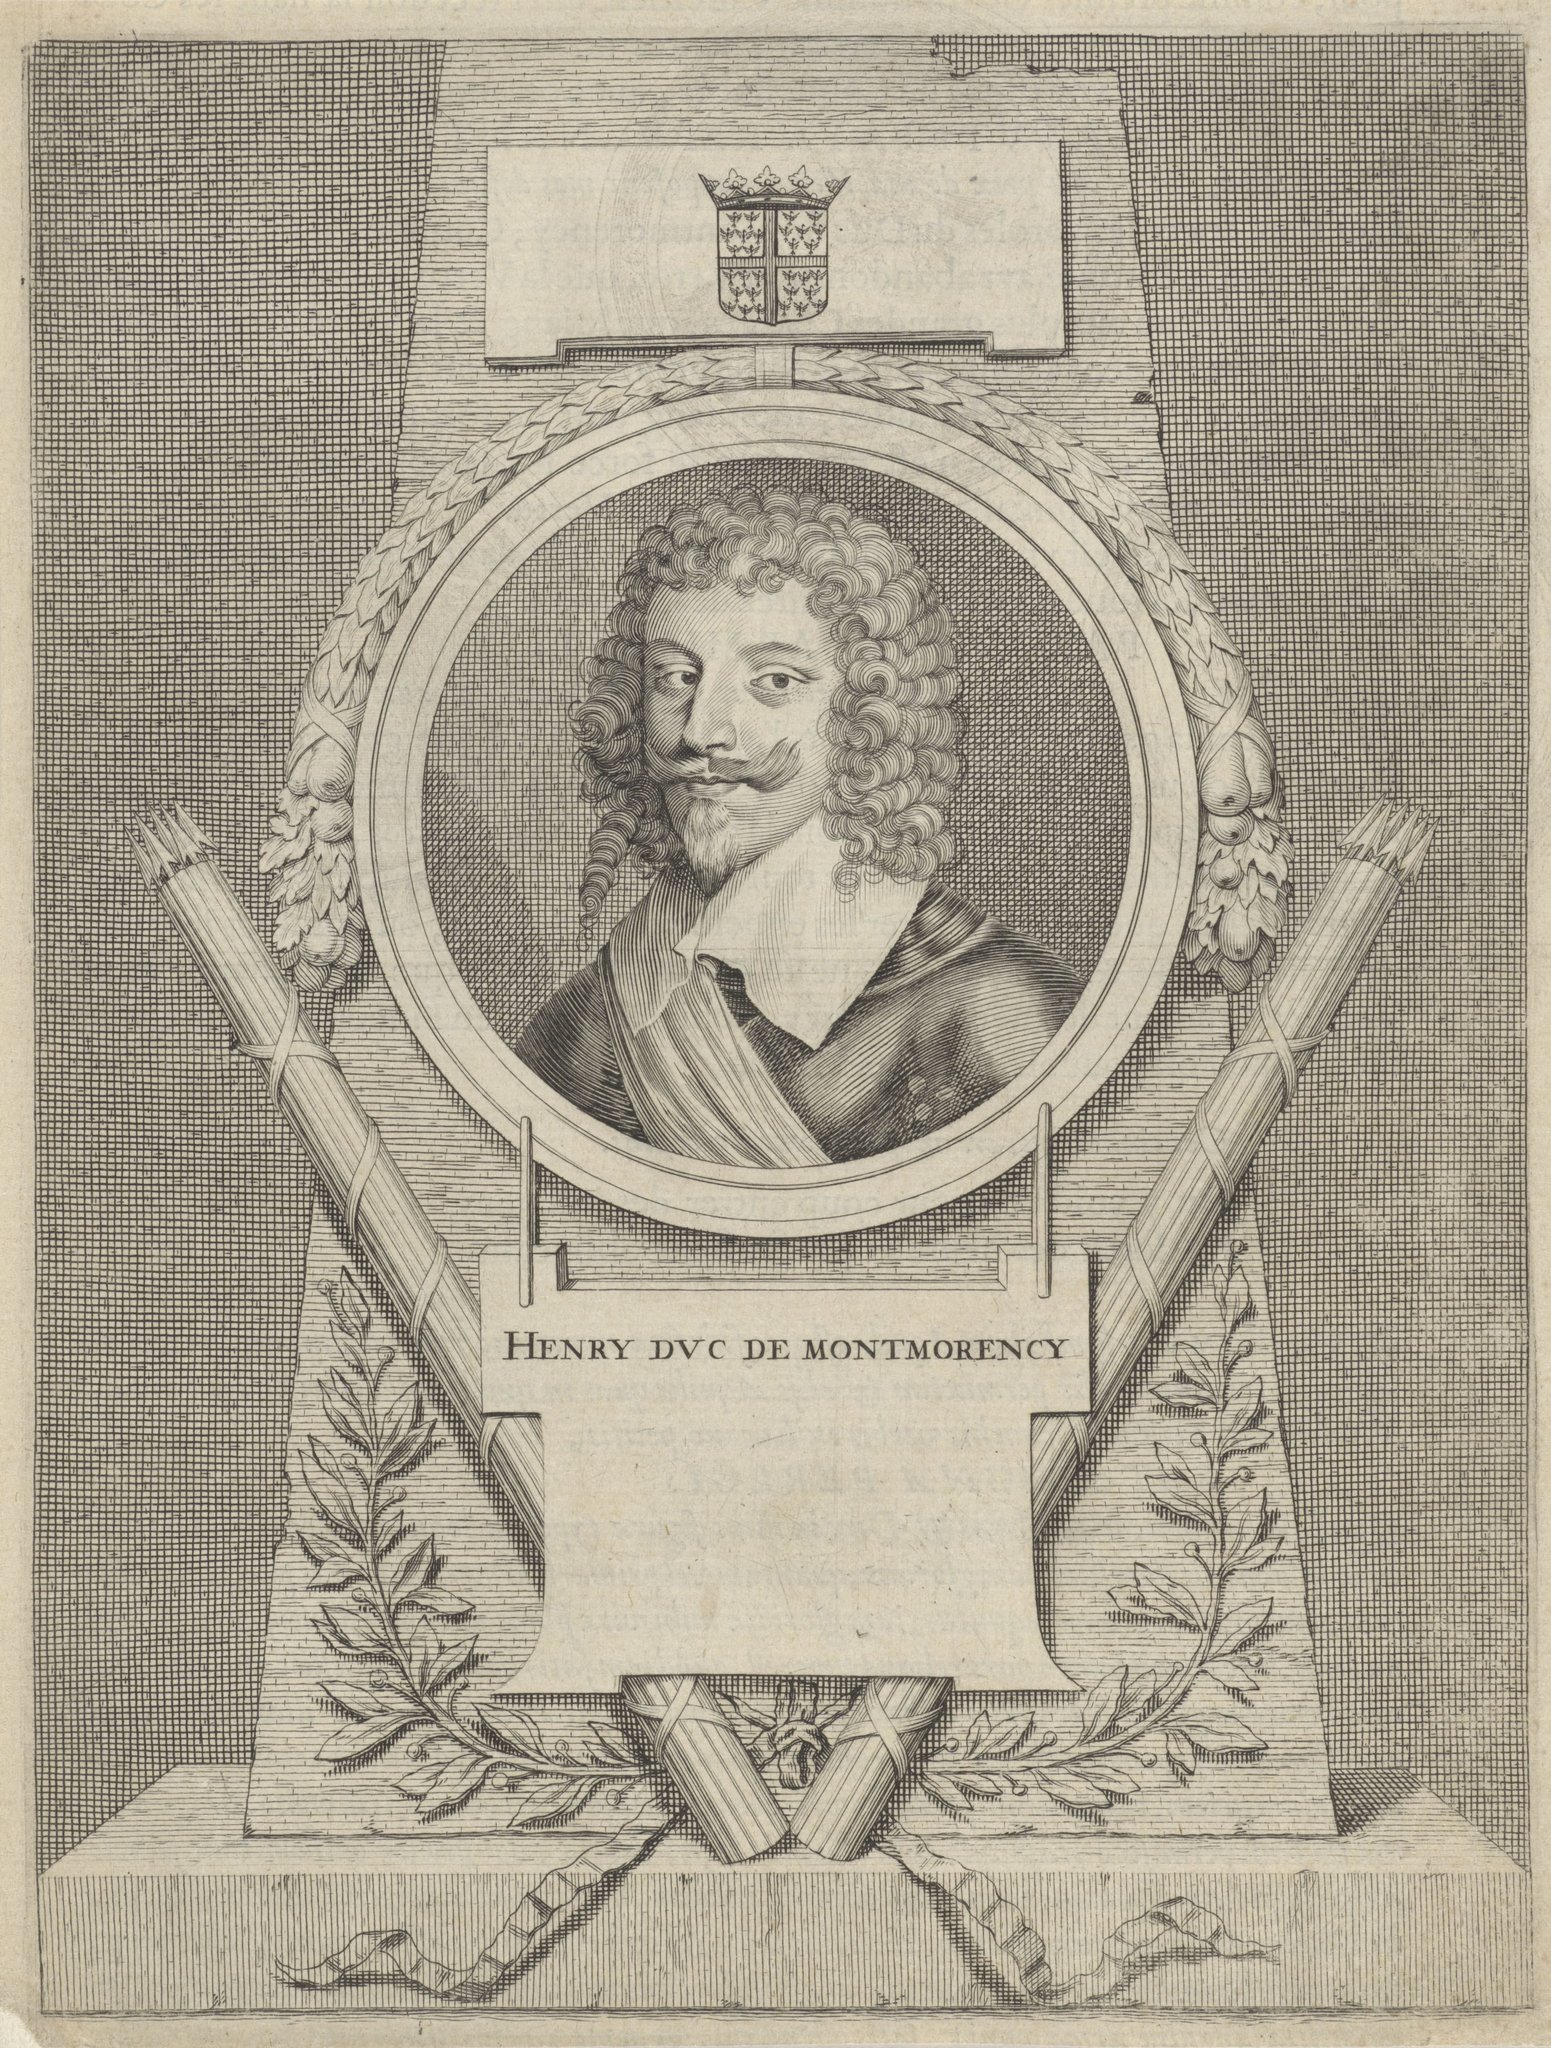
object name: book illustration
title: Portret van Henry duc de Montmorency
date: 1649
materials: paper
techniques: engraving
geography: paris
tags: chantilly, lodewijk xiii (koning van frankrijk)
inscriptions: collector's mark: Lugt 2228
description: Boekillustratie in: Estienne, Henry. Devises des roys, princes et generaux d'armees qui ont assiste ou servy Louis le Juste combattant. In: Les Triomphes de Louis le Juste XIII. Parijs: A. Estienne, 1649.